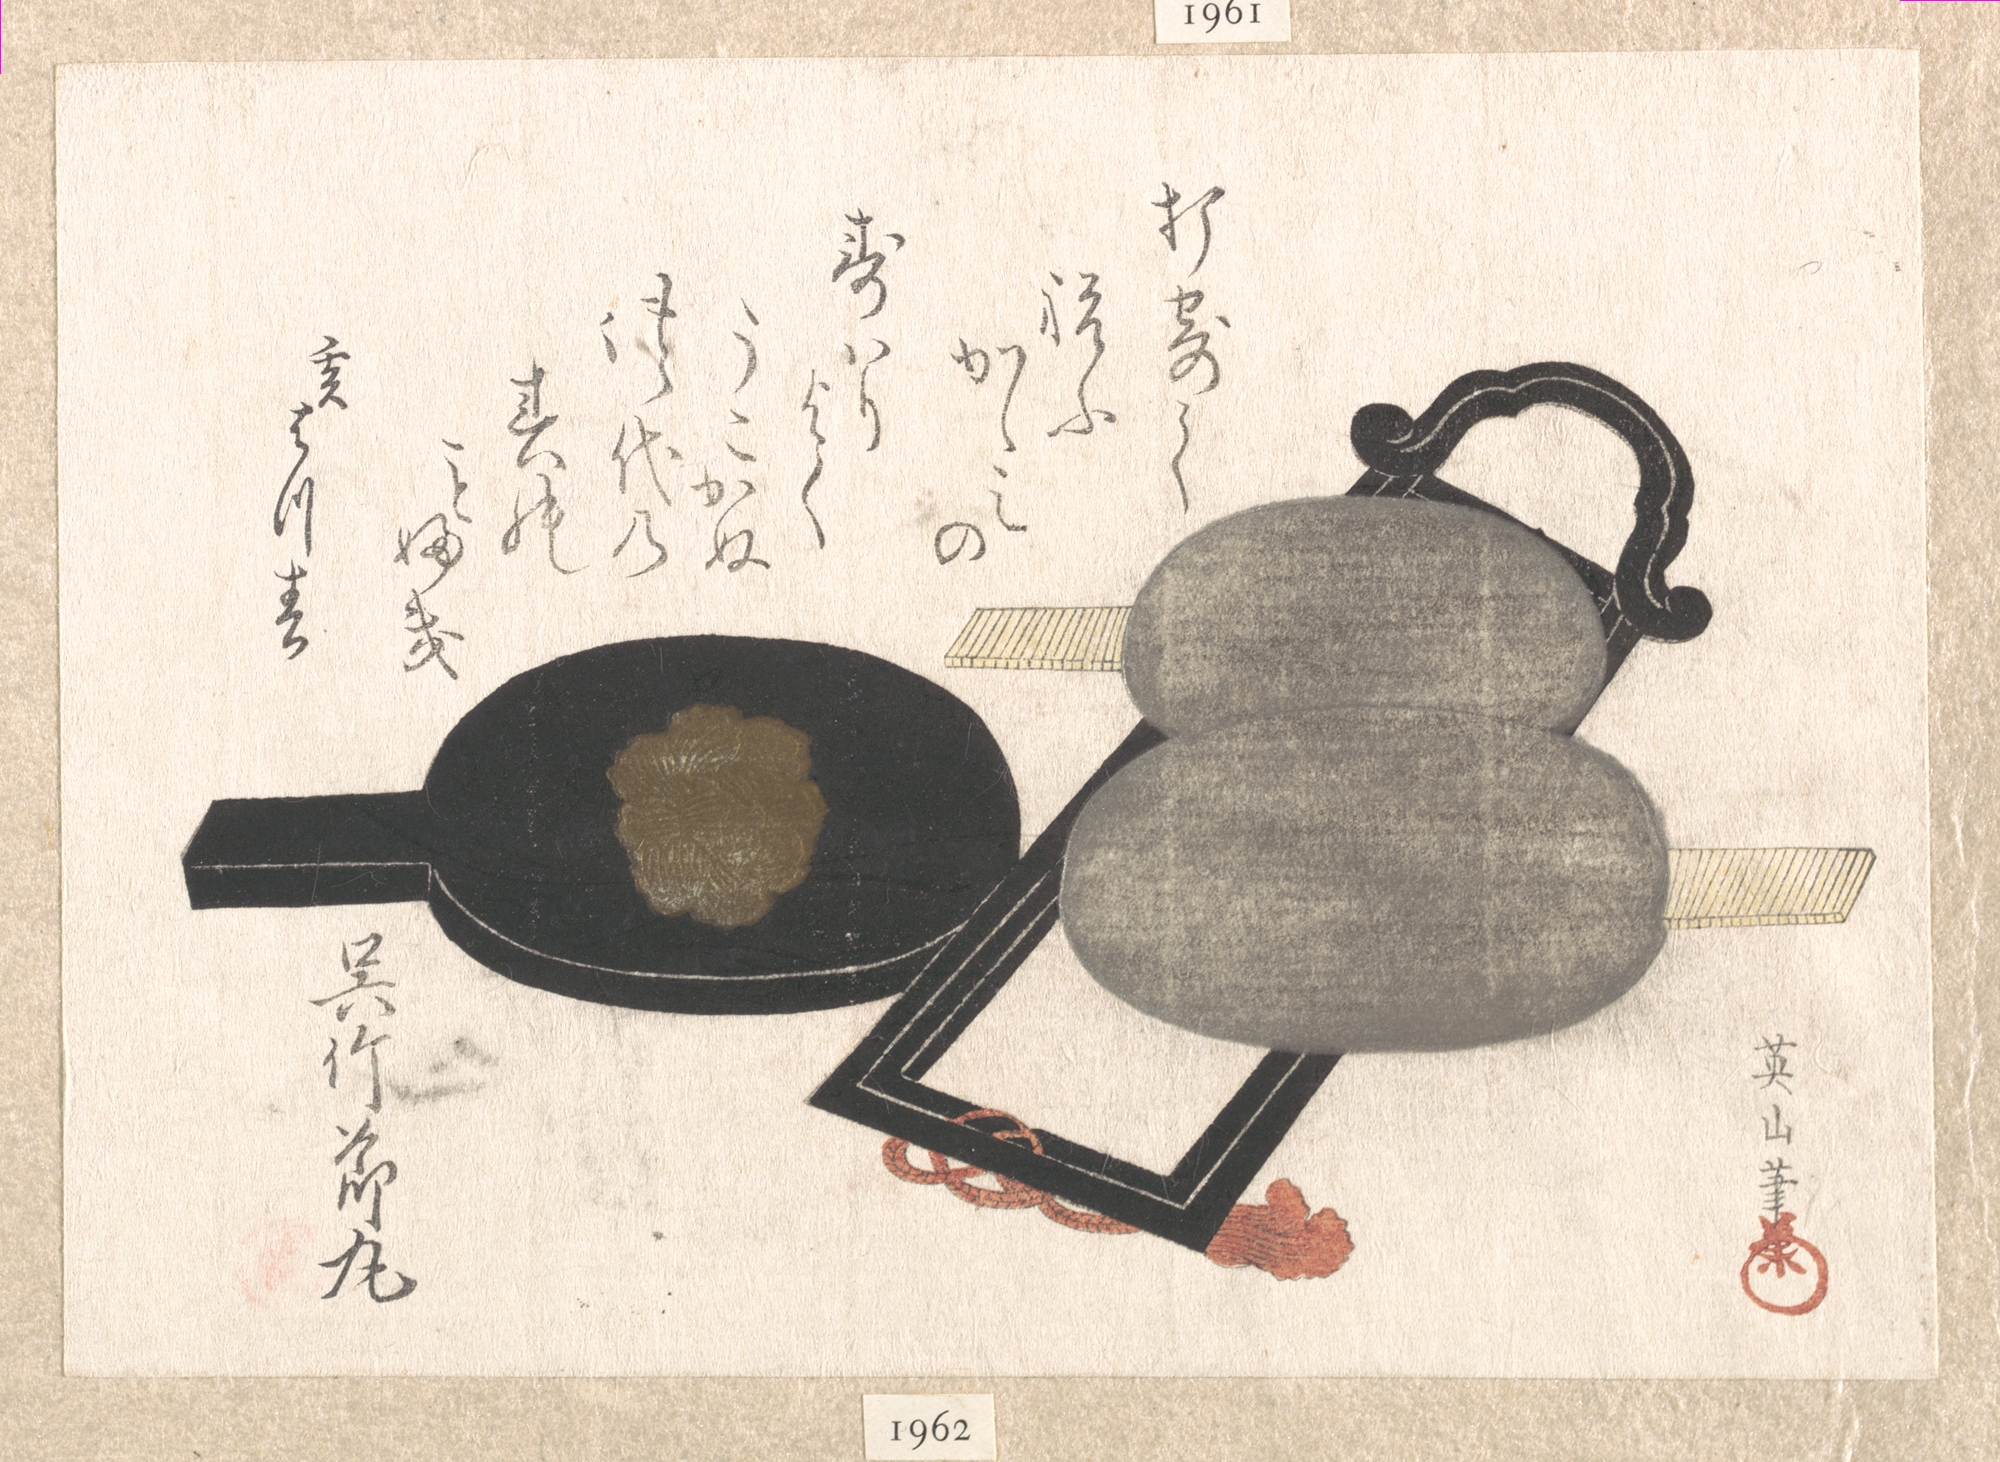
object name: print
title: Mirror and Stand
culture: japanese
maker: kikugawa eizan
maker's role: artist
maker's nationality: japanese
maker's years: 1787-1867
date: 1815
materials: ink, paper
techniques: surimono, woodblock print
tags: mirrors